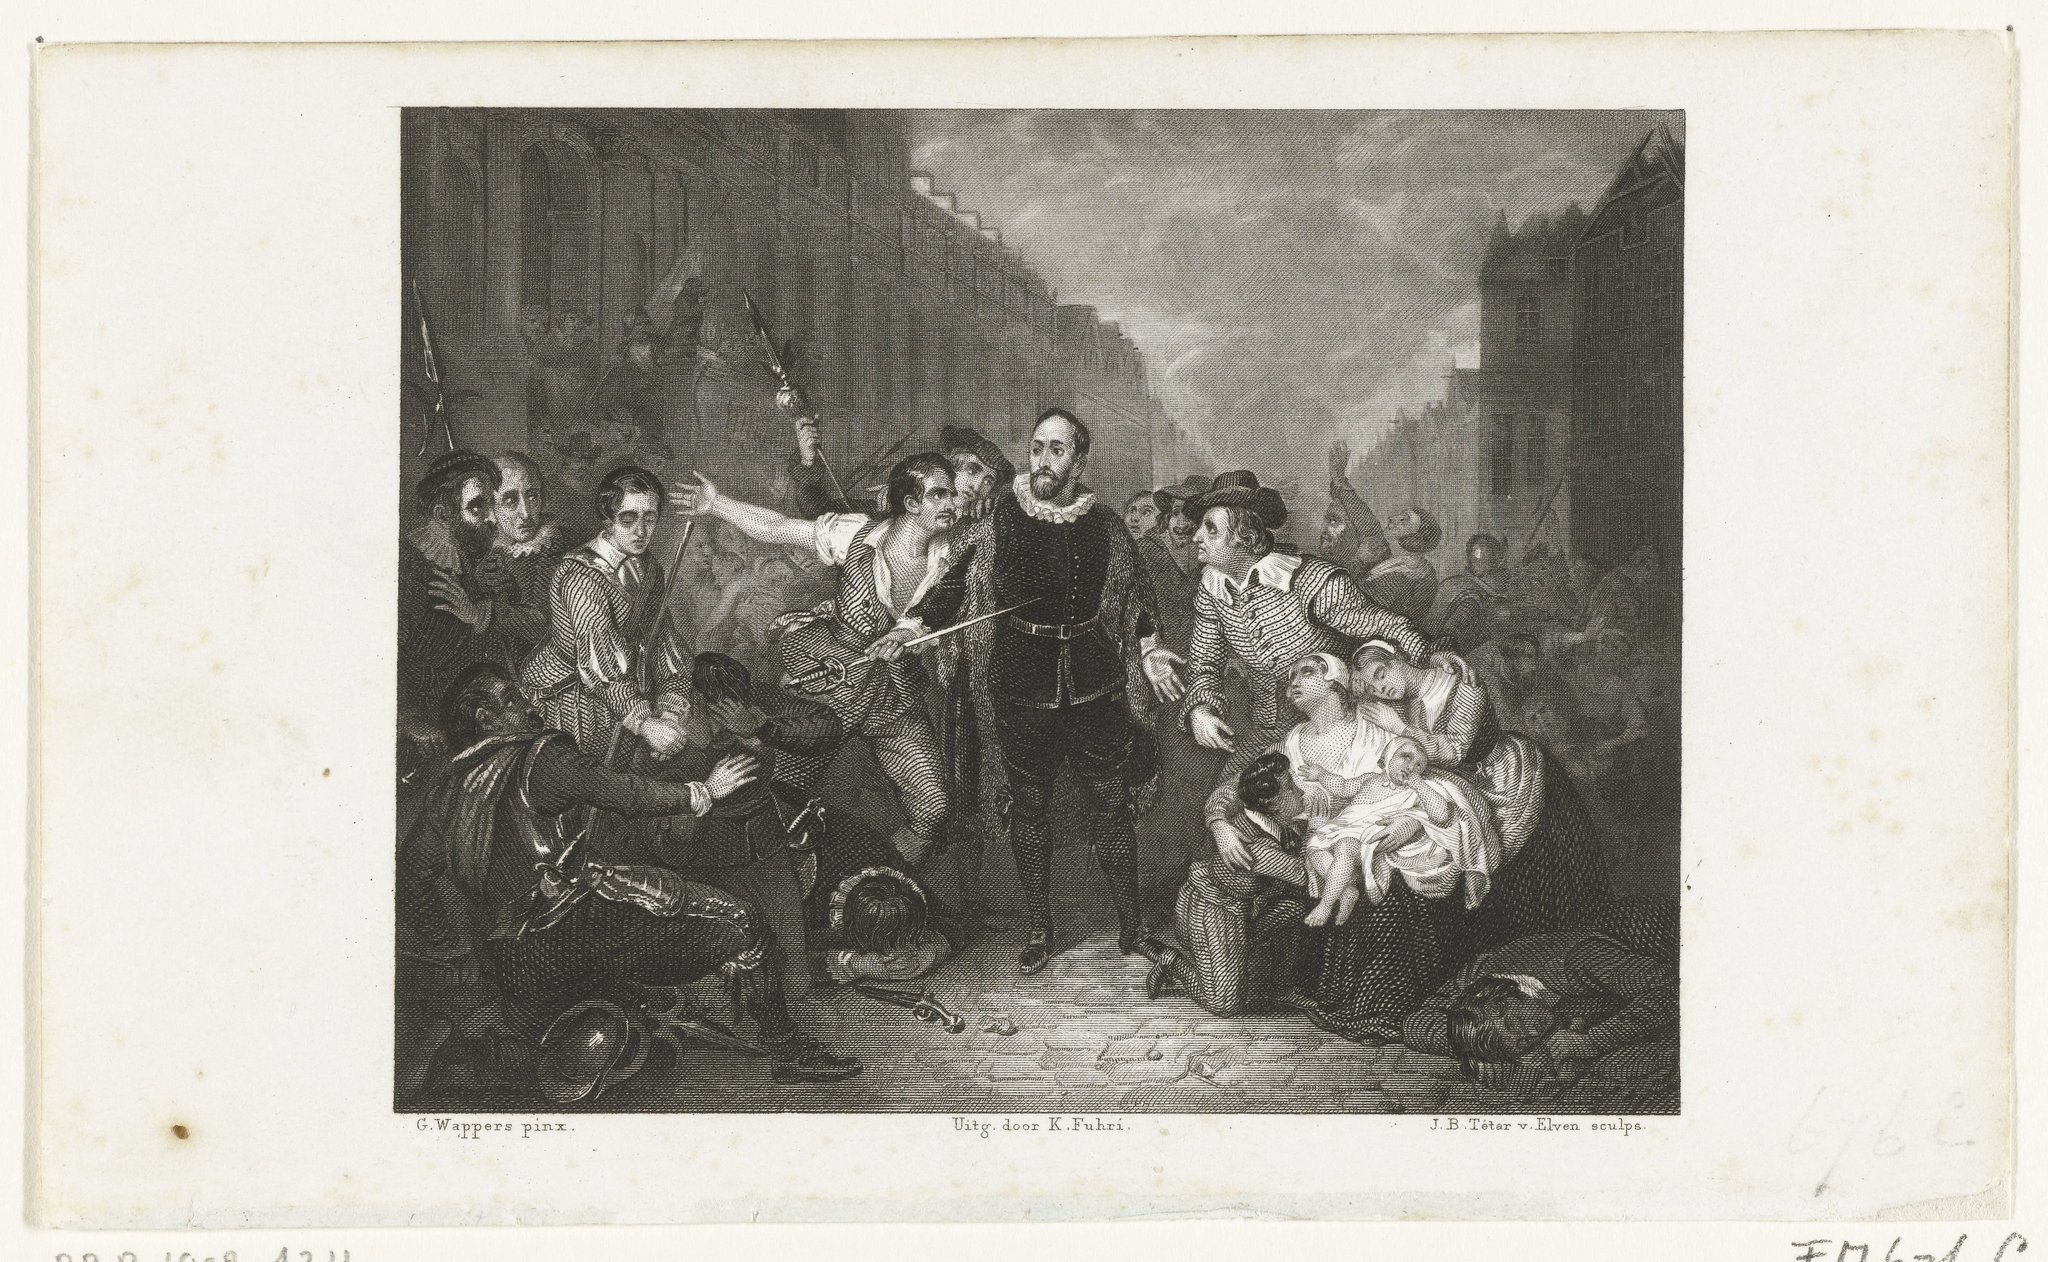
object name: print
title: De zelfopoffering van burgemeester Pieter van der Werff, 1574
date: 1815-1889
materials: paper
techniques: engraving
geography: netherlands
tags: mayor, leiden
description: De zelfopoffering van burgemeester Pieter van der Werff, tijdens het beleg van Leiden, 1574. Van der Werff staande op straat voor knielende en op straat zittende Leidenaren en biedt hen zijn zwaard en lichaam aan. Het schilderij van M.I. van Bree.